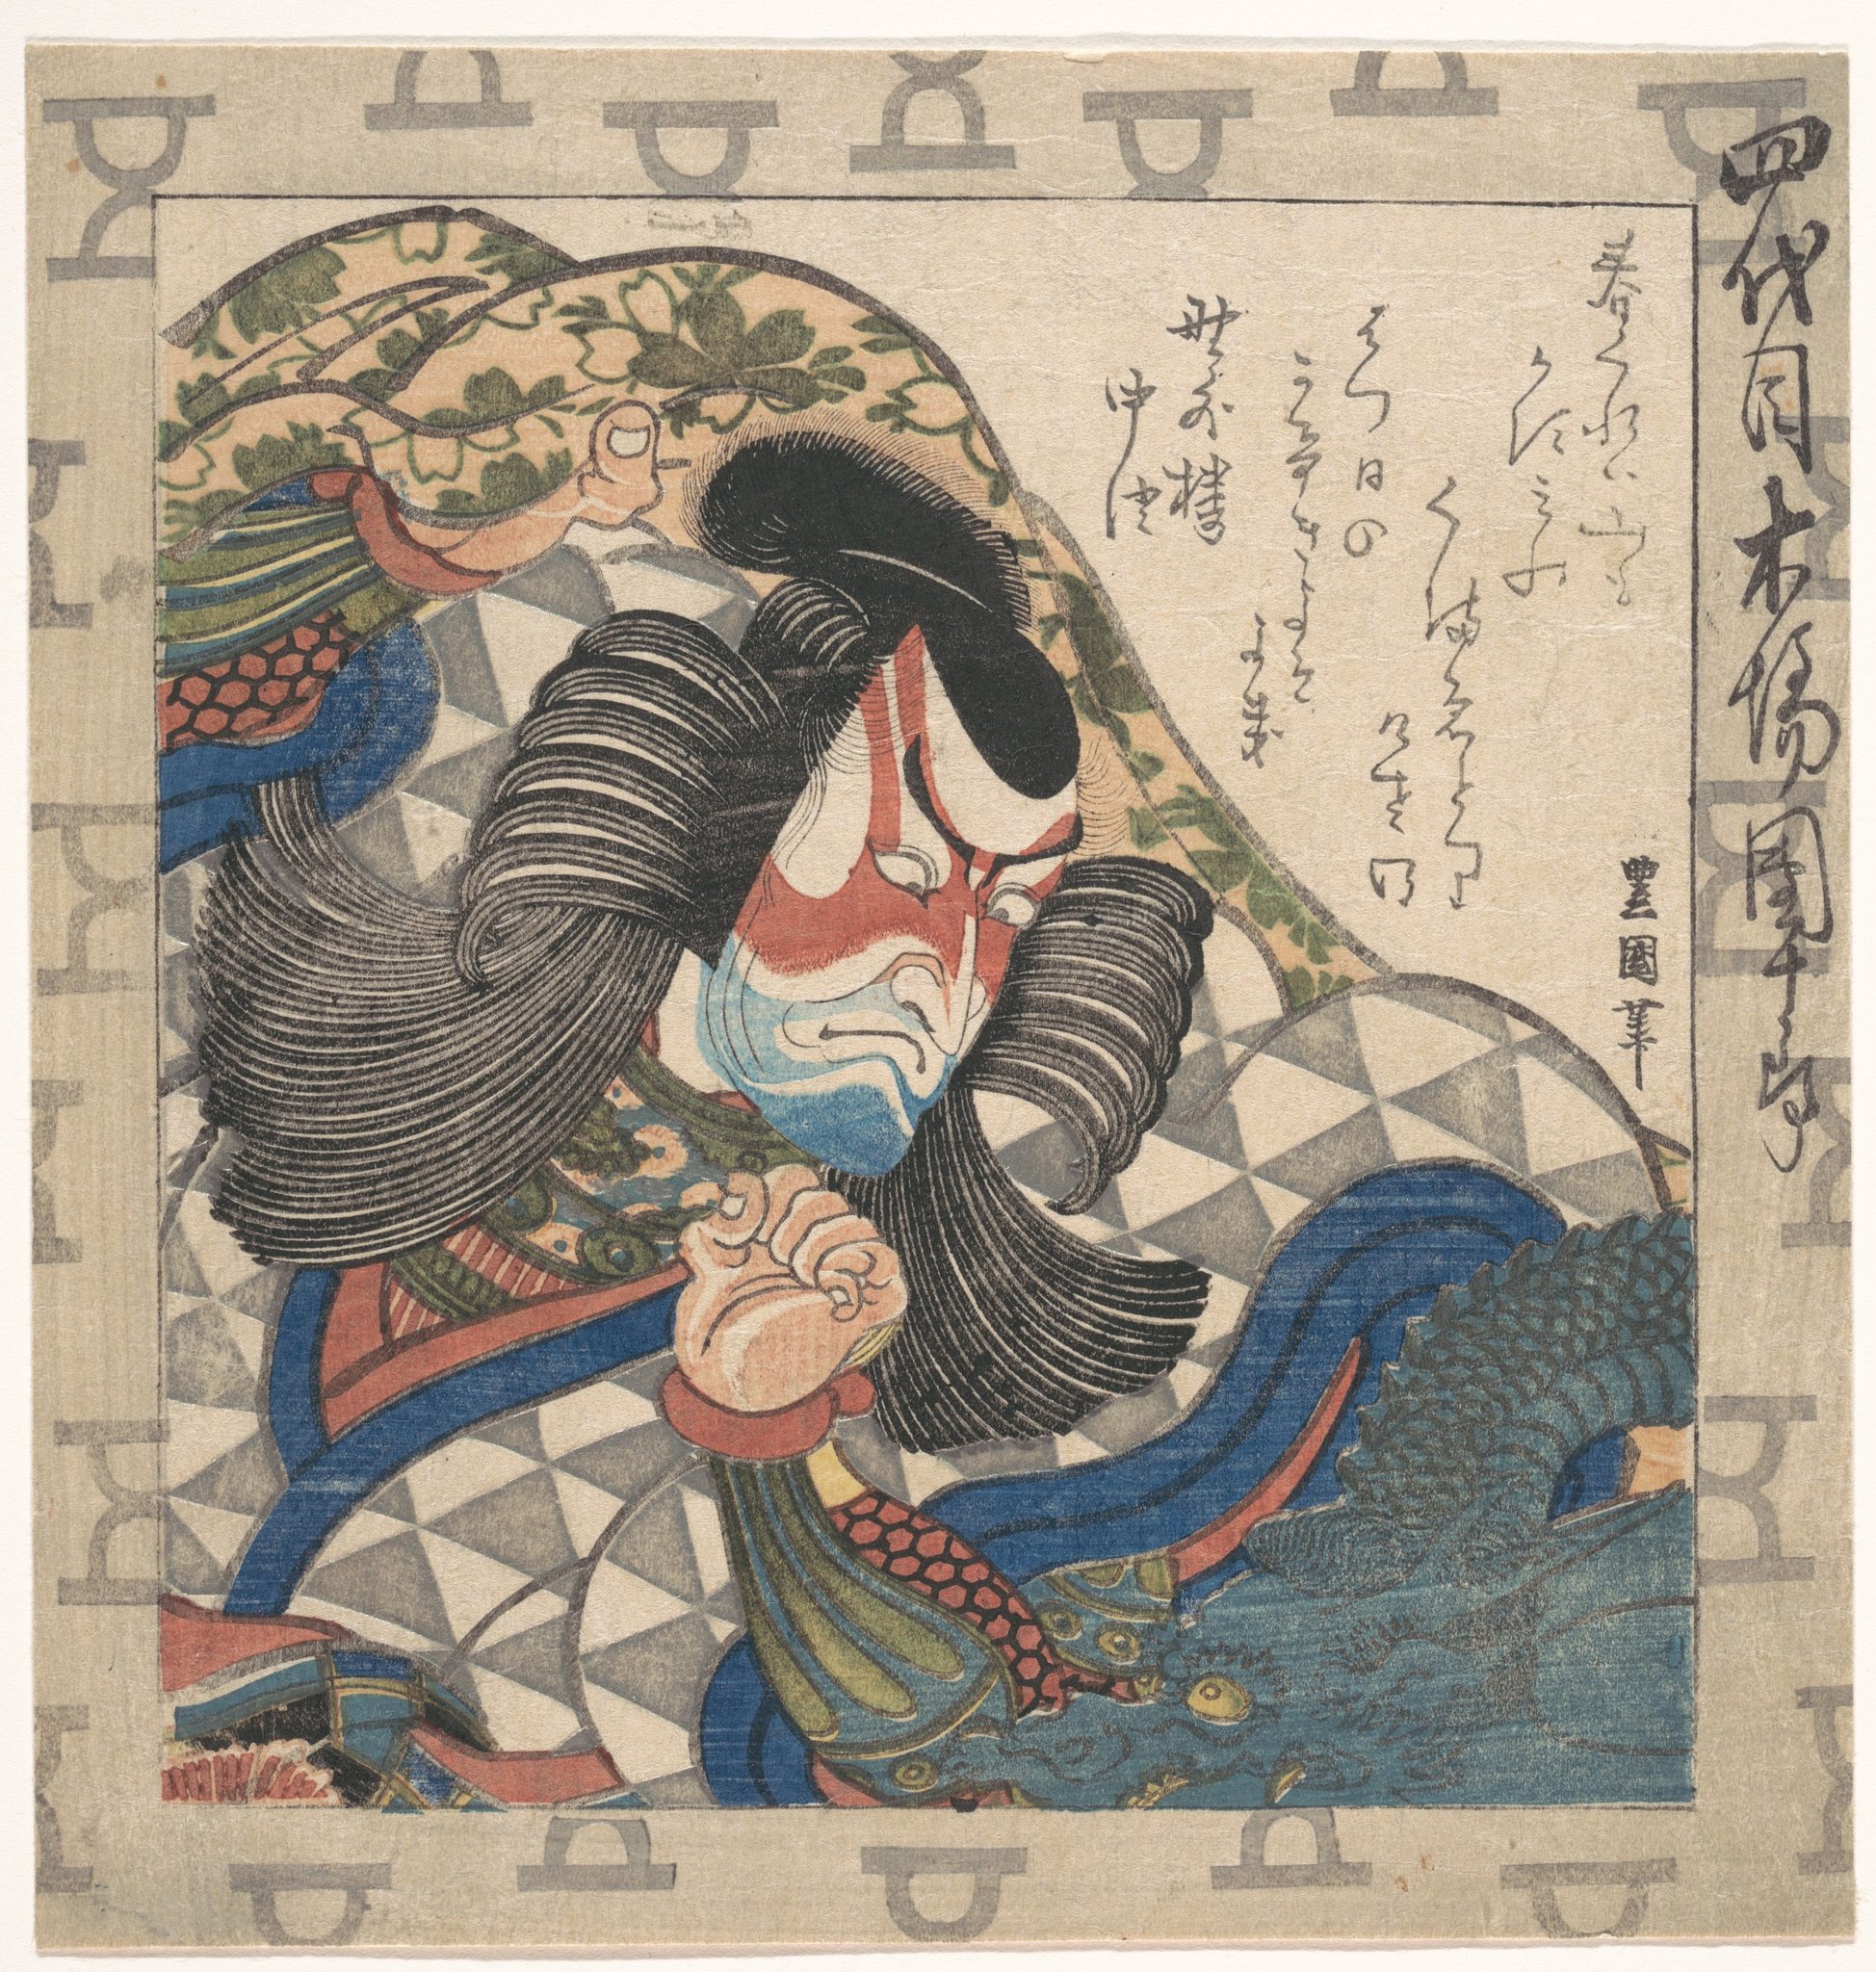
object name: print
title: Ichikawa Danjuro IV in the Role of Kagekiyo in the Play Enlightenment from a Series of Portraits of Danjūrō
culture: japanese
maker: utagawa toyokuni ii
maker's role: artist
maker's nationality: japanese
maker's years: 1777-1835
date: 1834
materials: ink, paper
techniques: surimono, woodblock print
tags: theatre,men,actors